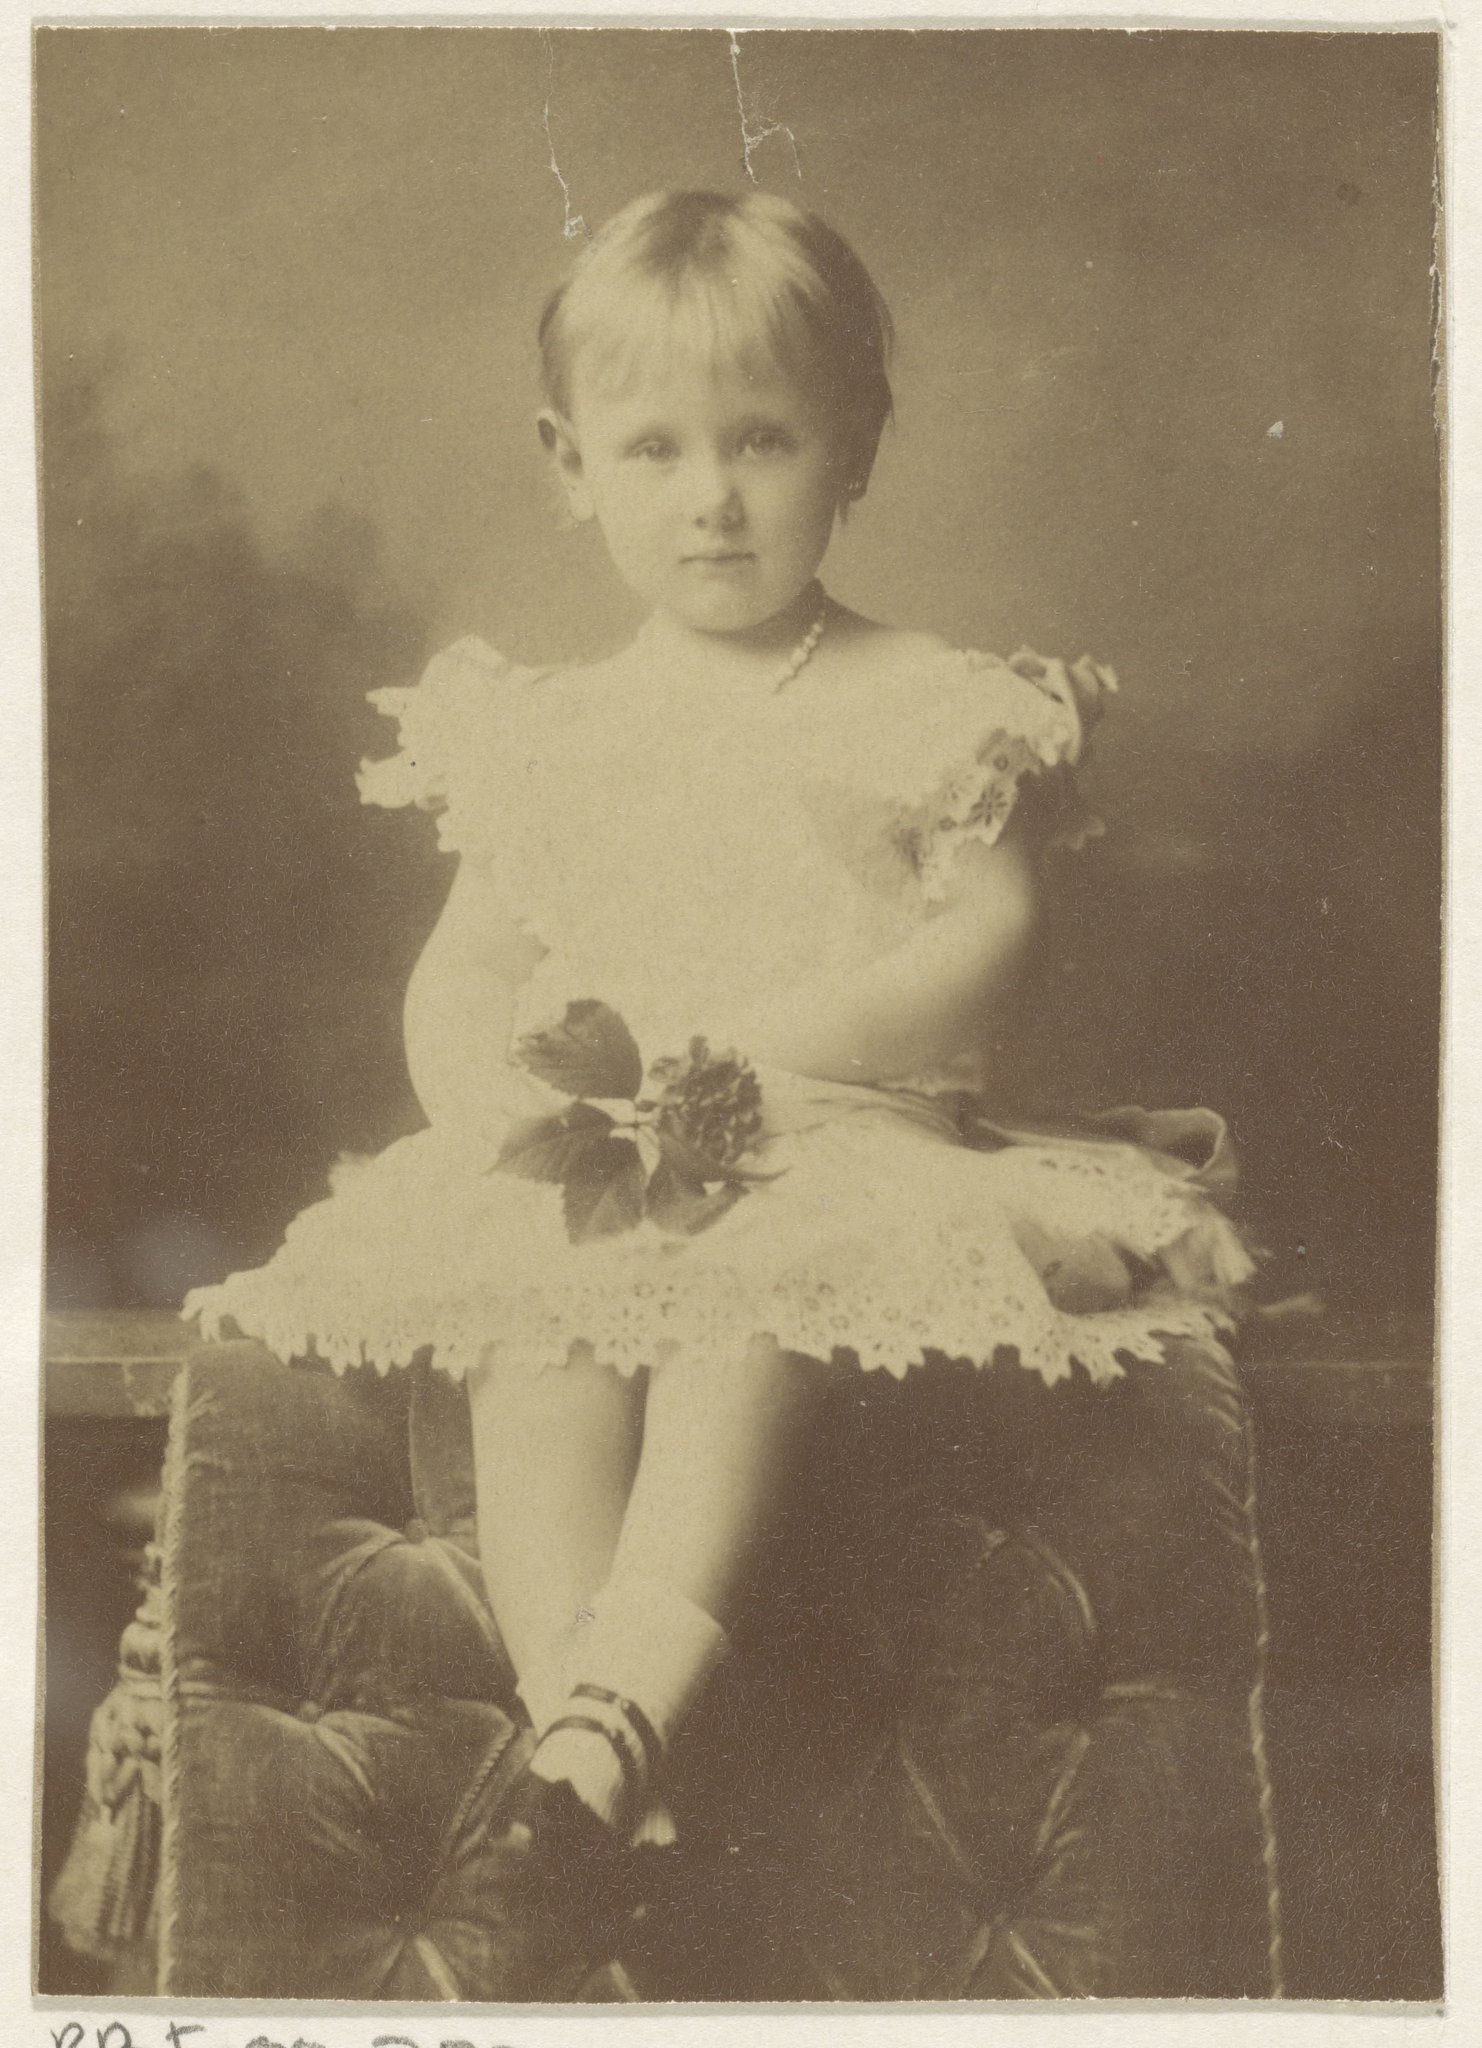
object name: photograph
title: Portret van Wilhelmina, koningin der Nederlanden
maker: Anonymous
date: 1882-1883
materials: paper, photographic support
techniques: albumen print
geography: netherlands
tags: the hague, print maker, wilhelmina of the netherlands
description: De hier vermelde titel verwijst naar de hoogst verkregen titel van de geportretteerde, niet per se naar de titel die de geportretteerde op deze voorstelling draagt.